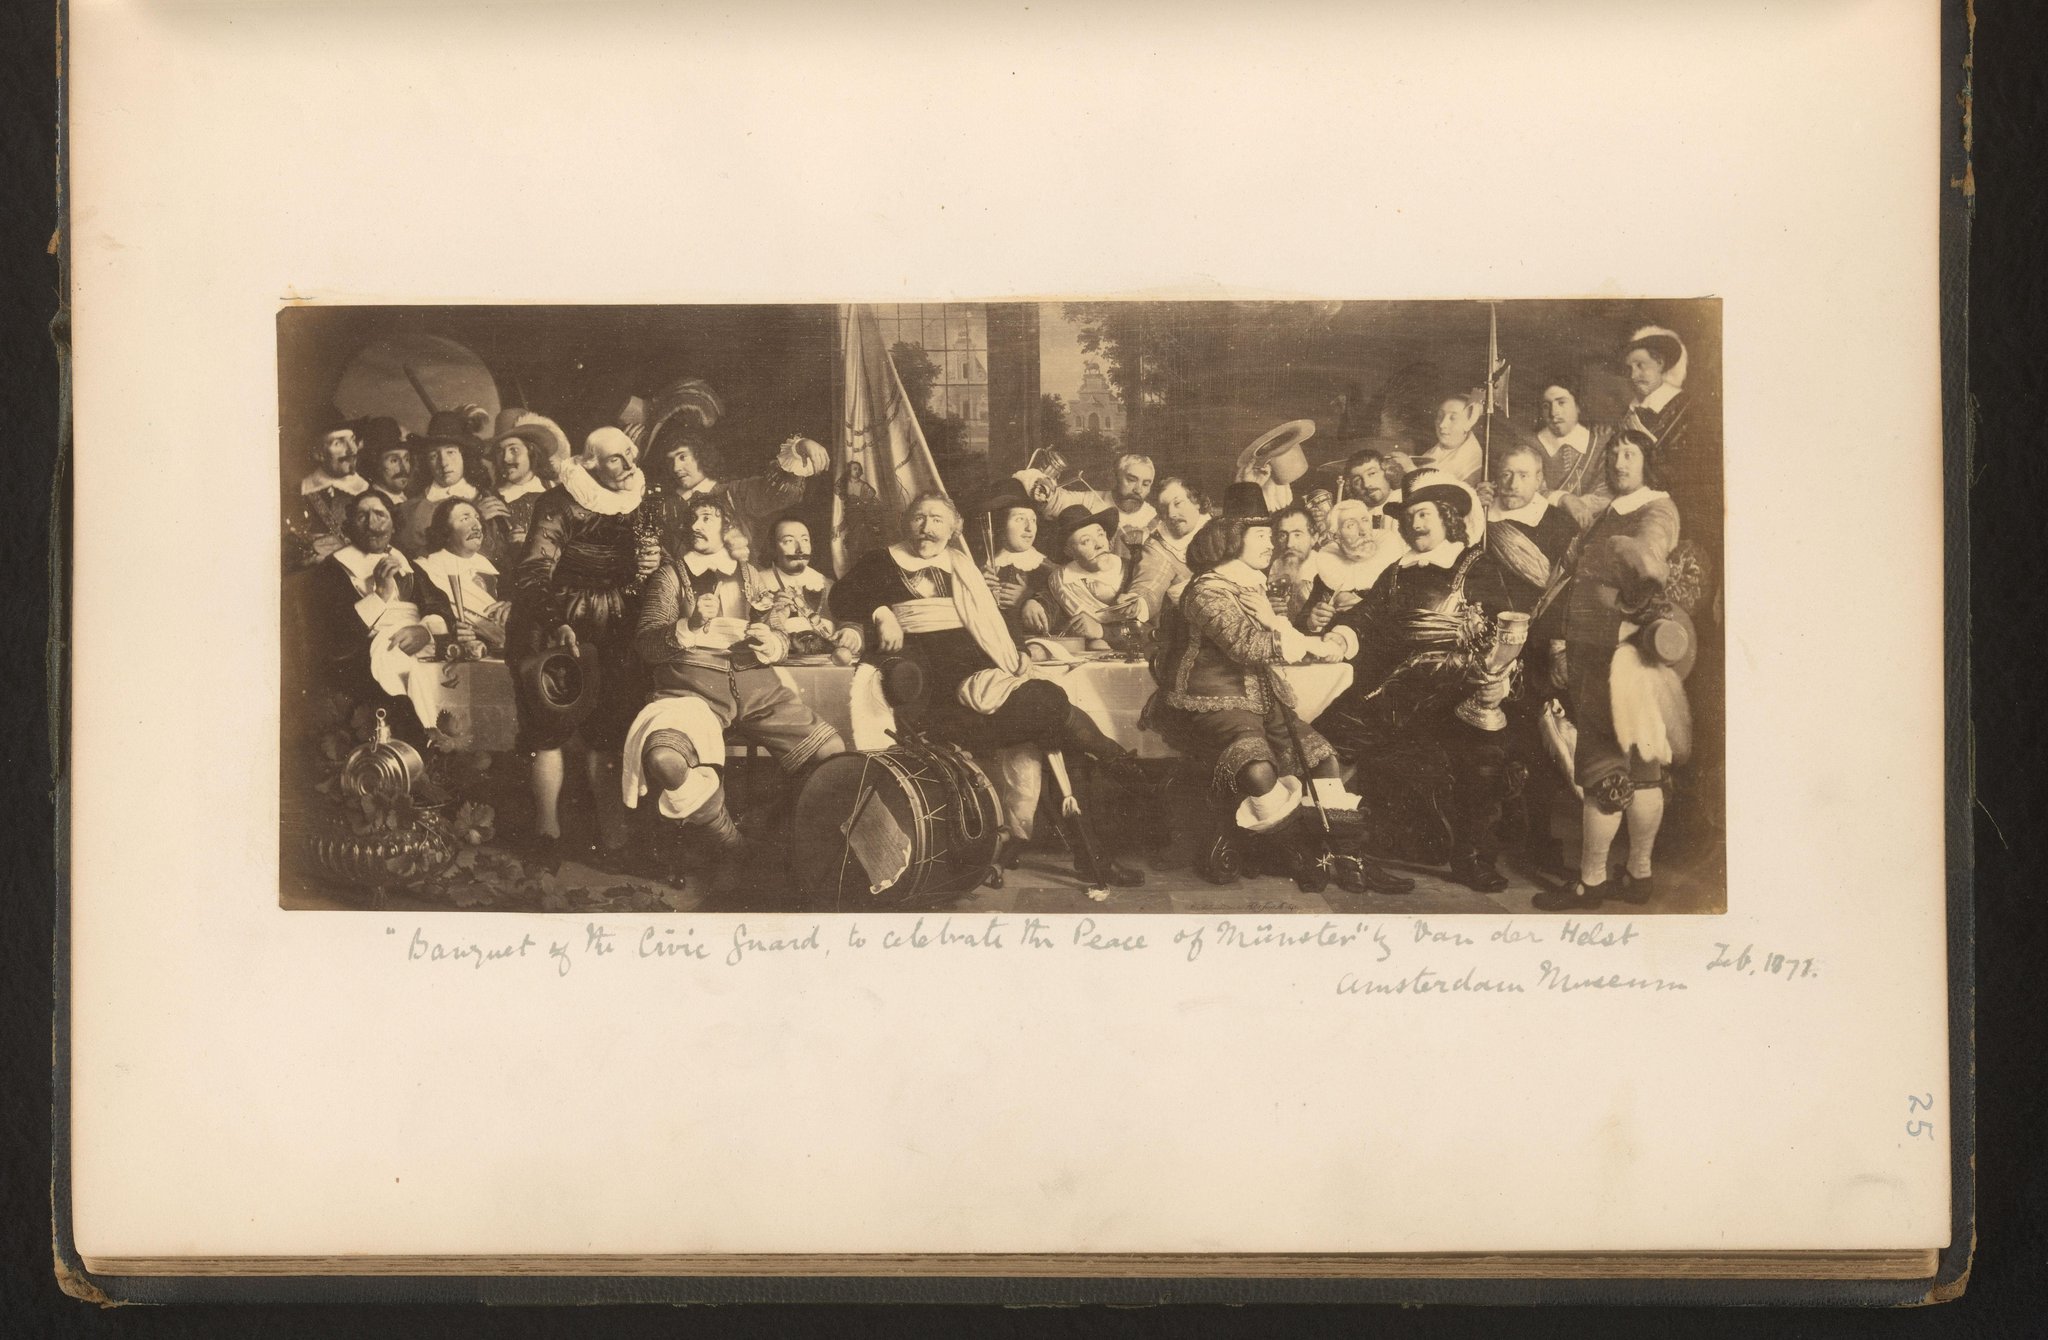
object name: reproduction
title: Fotoreproductie van de Schuttersmaaltijd ter viering van de Vrede van Munster van Bartholomeus van der Helst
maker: Anonymous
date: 1802-1871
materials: paper, photographic support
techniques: albumen print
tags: warfare; military affairs (+ citizen soldiery, civil guard, citizen militia), celebration meal, feast, banquet, picture, painting, private festivities, merry company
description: Deze pagina maakt deel uit van een album.